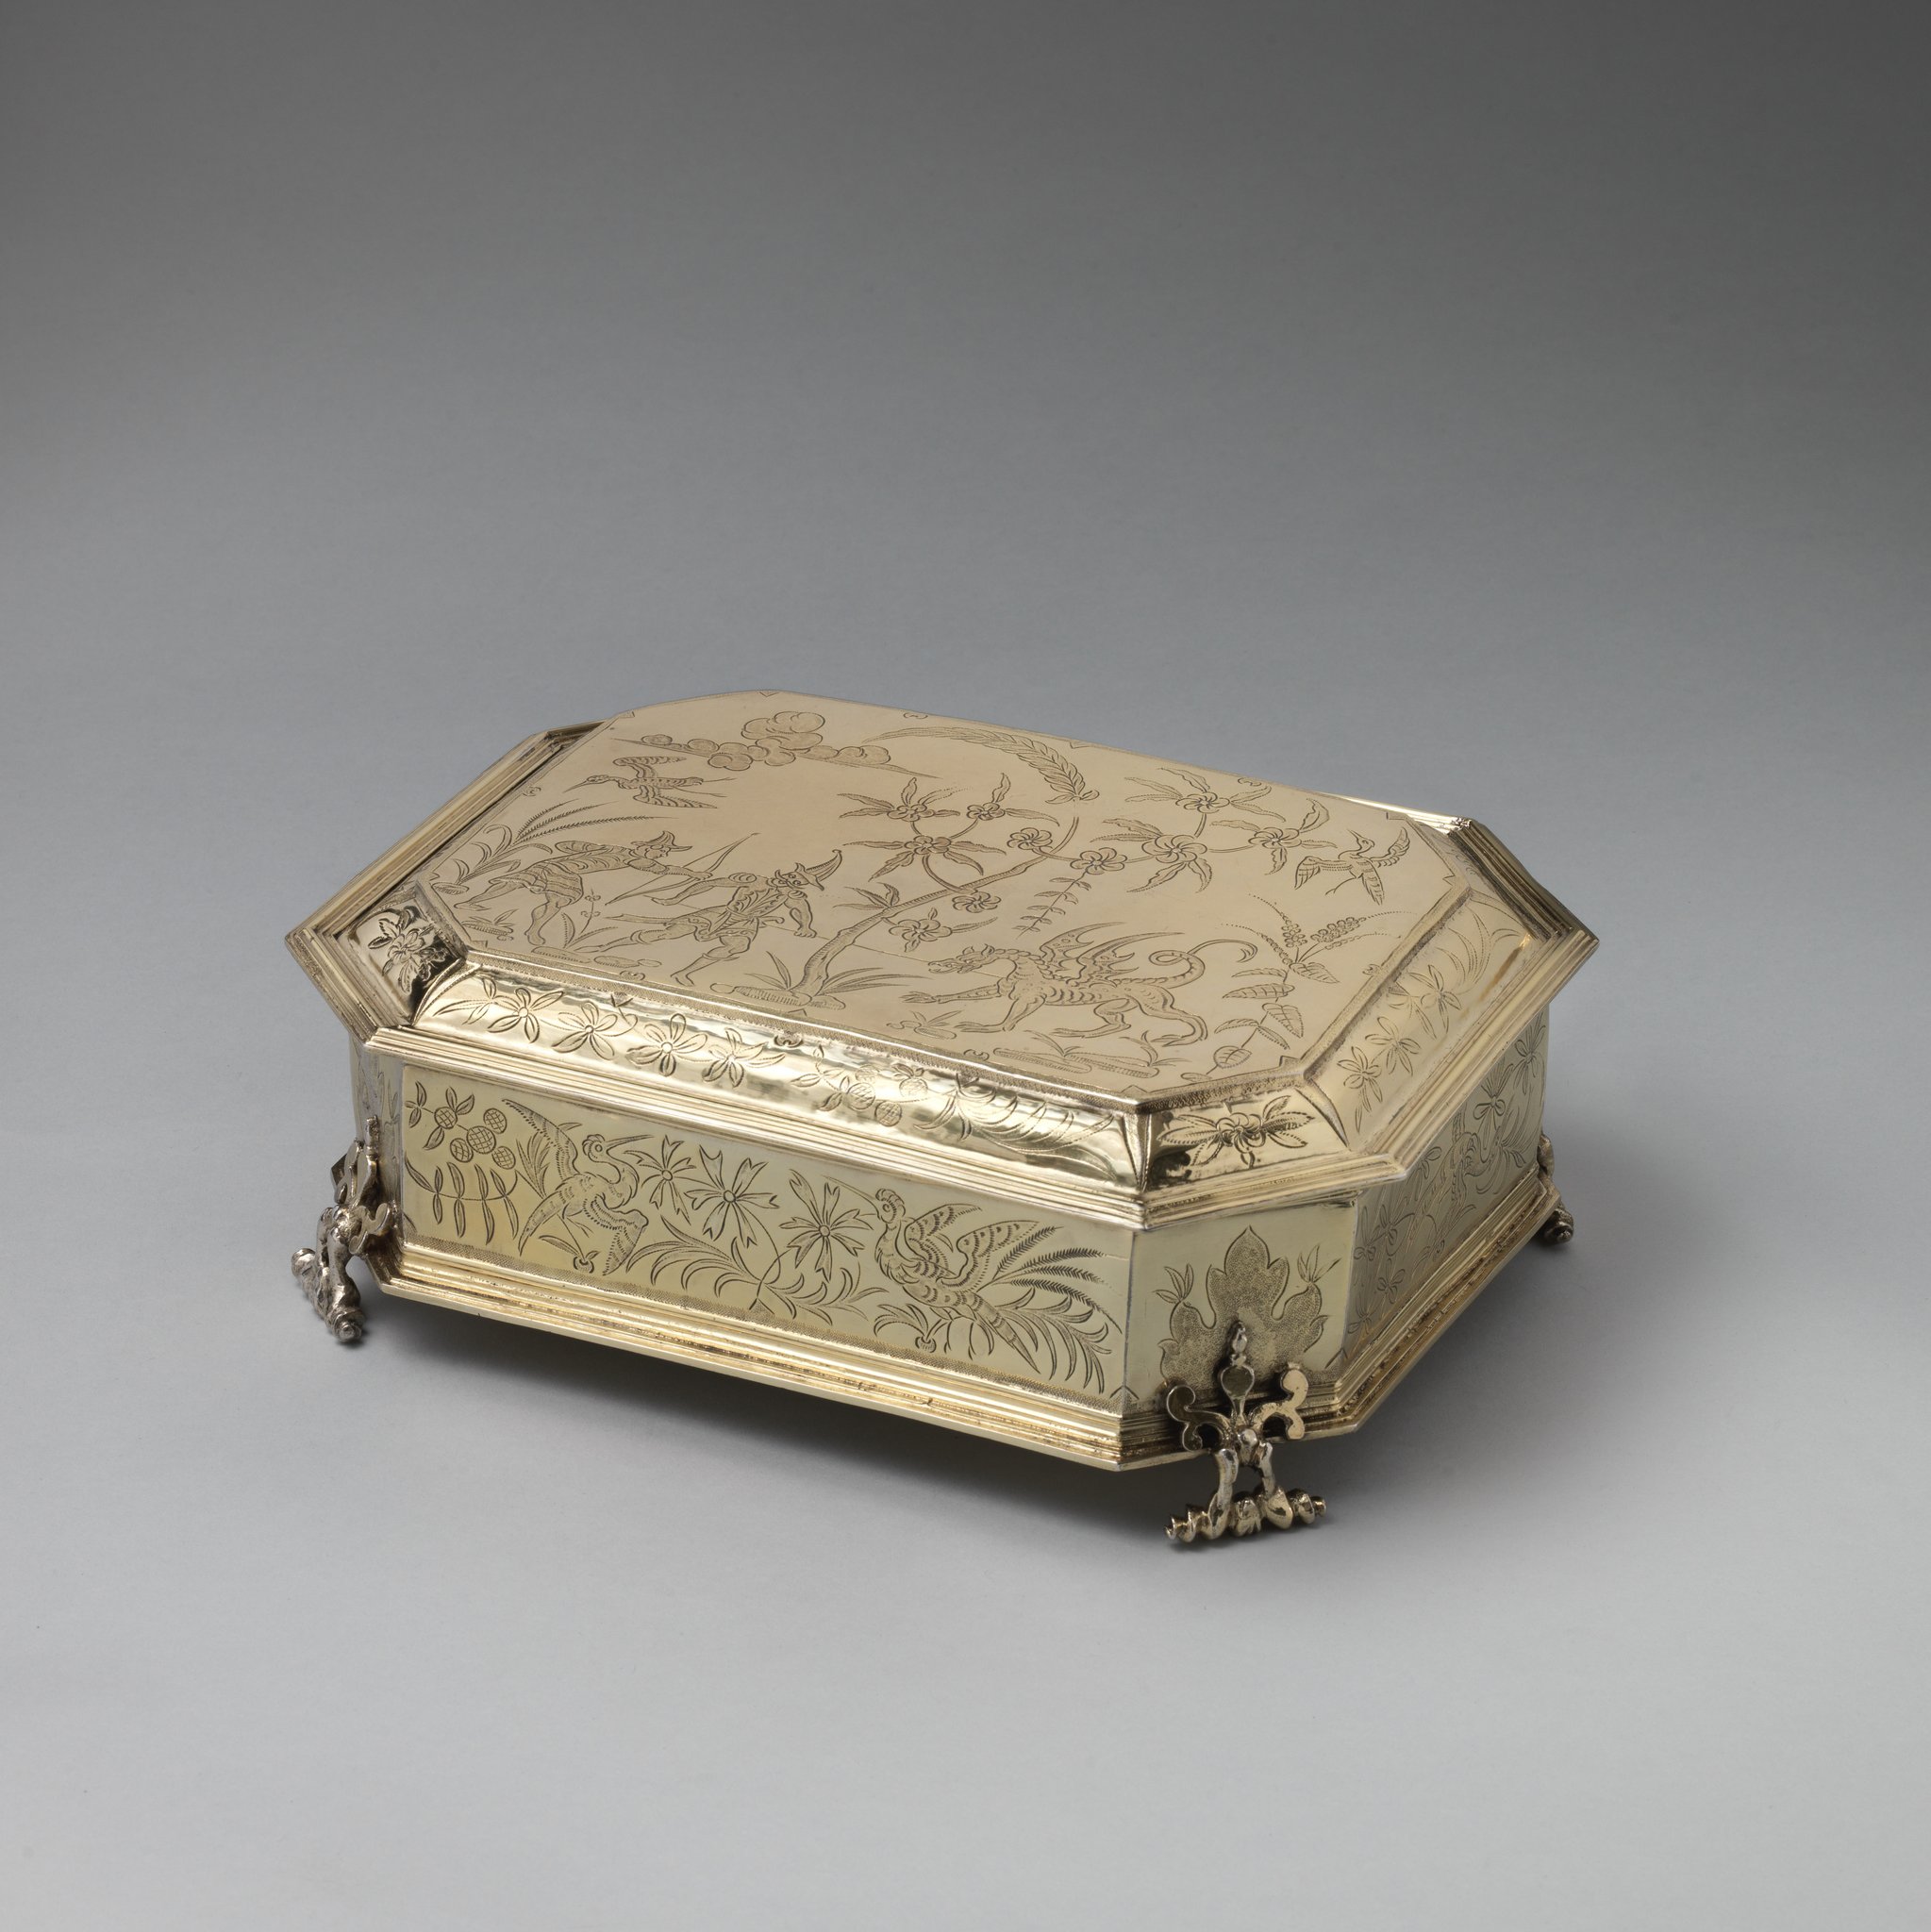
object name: casket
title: Casket (part of a toilet service)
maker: william fowle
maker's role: maker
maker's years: 1658-1684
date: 1683-1684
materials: silver gilt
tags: birds,men,dragons,flowers